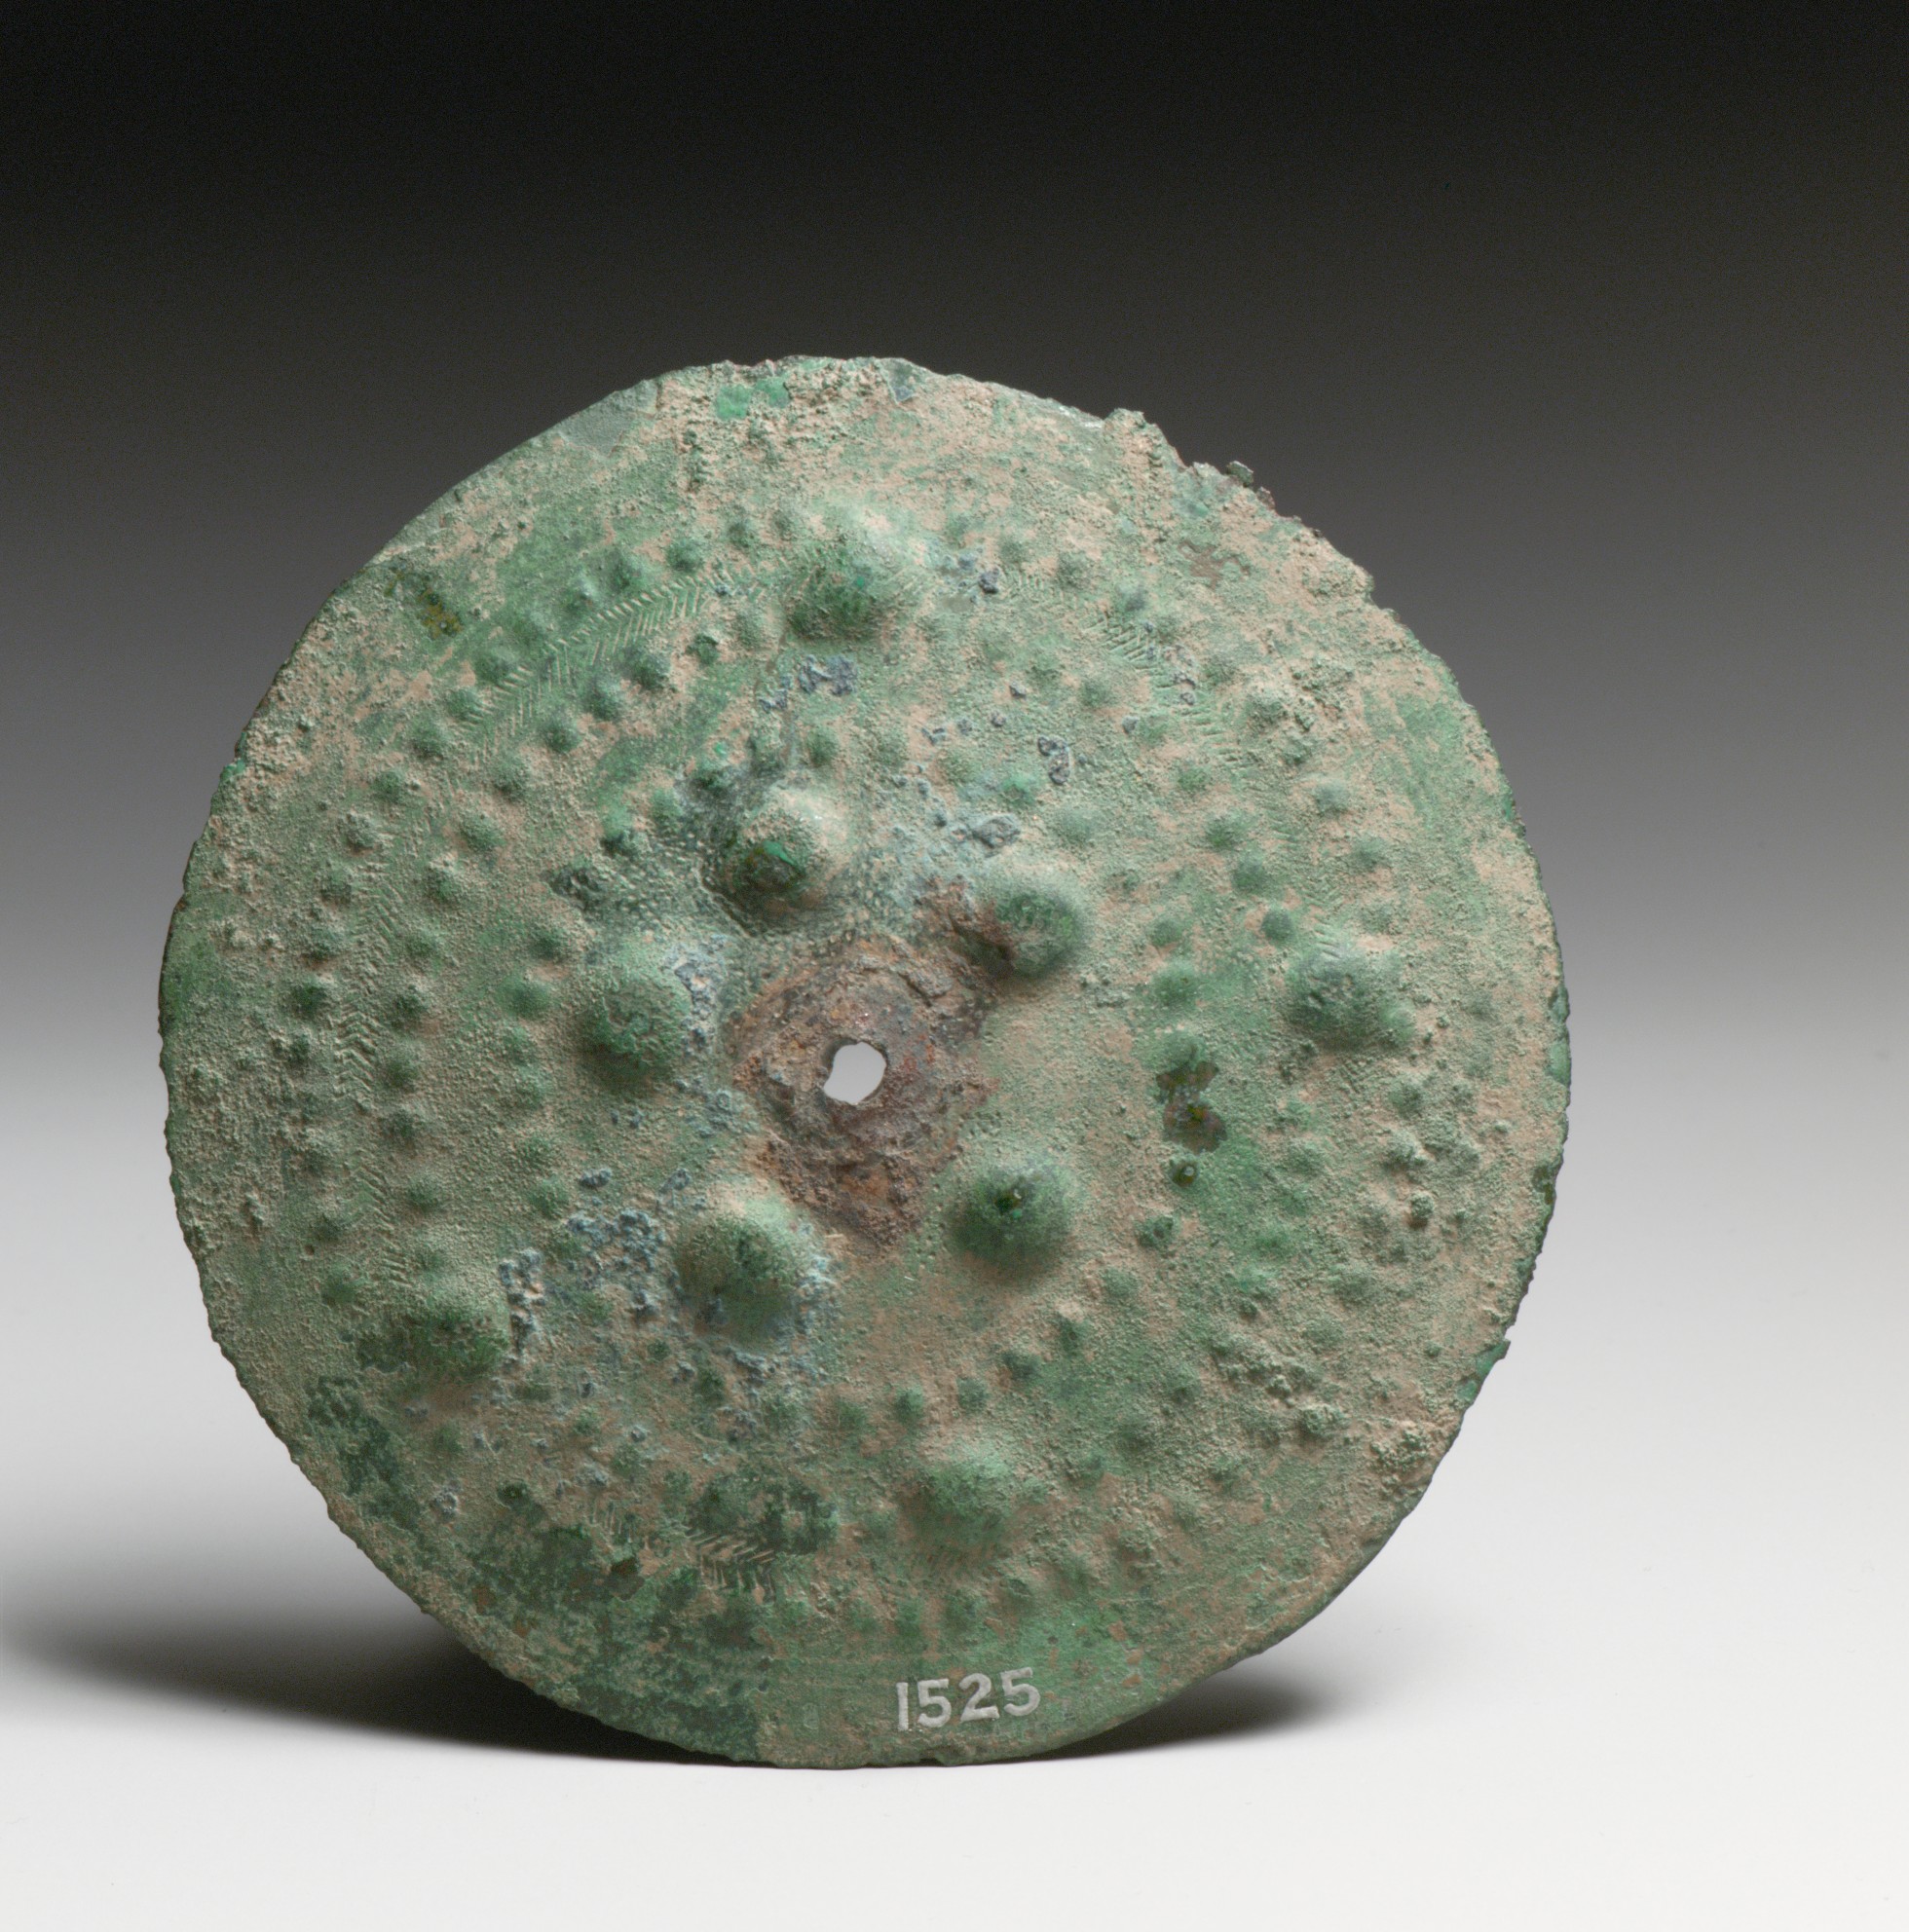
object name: disk, a shield bos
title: Bronze shield boss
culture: italic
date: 800-601 BCE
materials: bronze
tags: shields